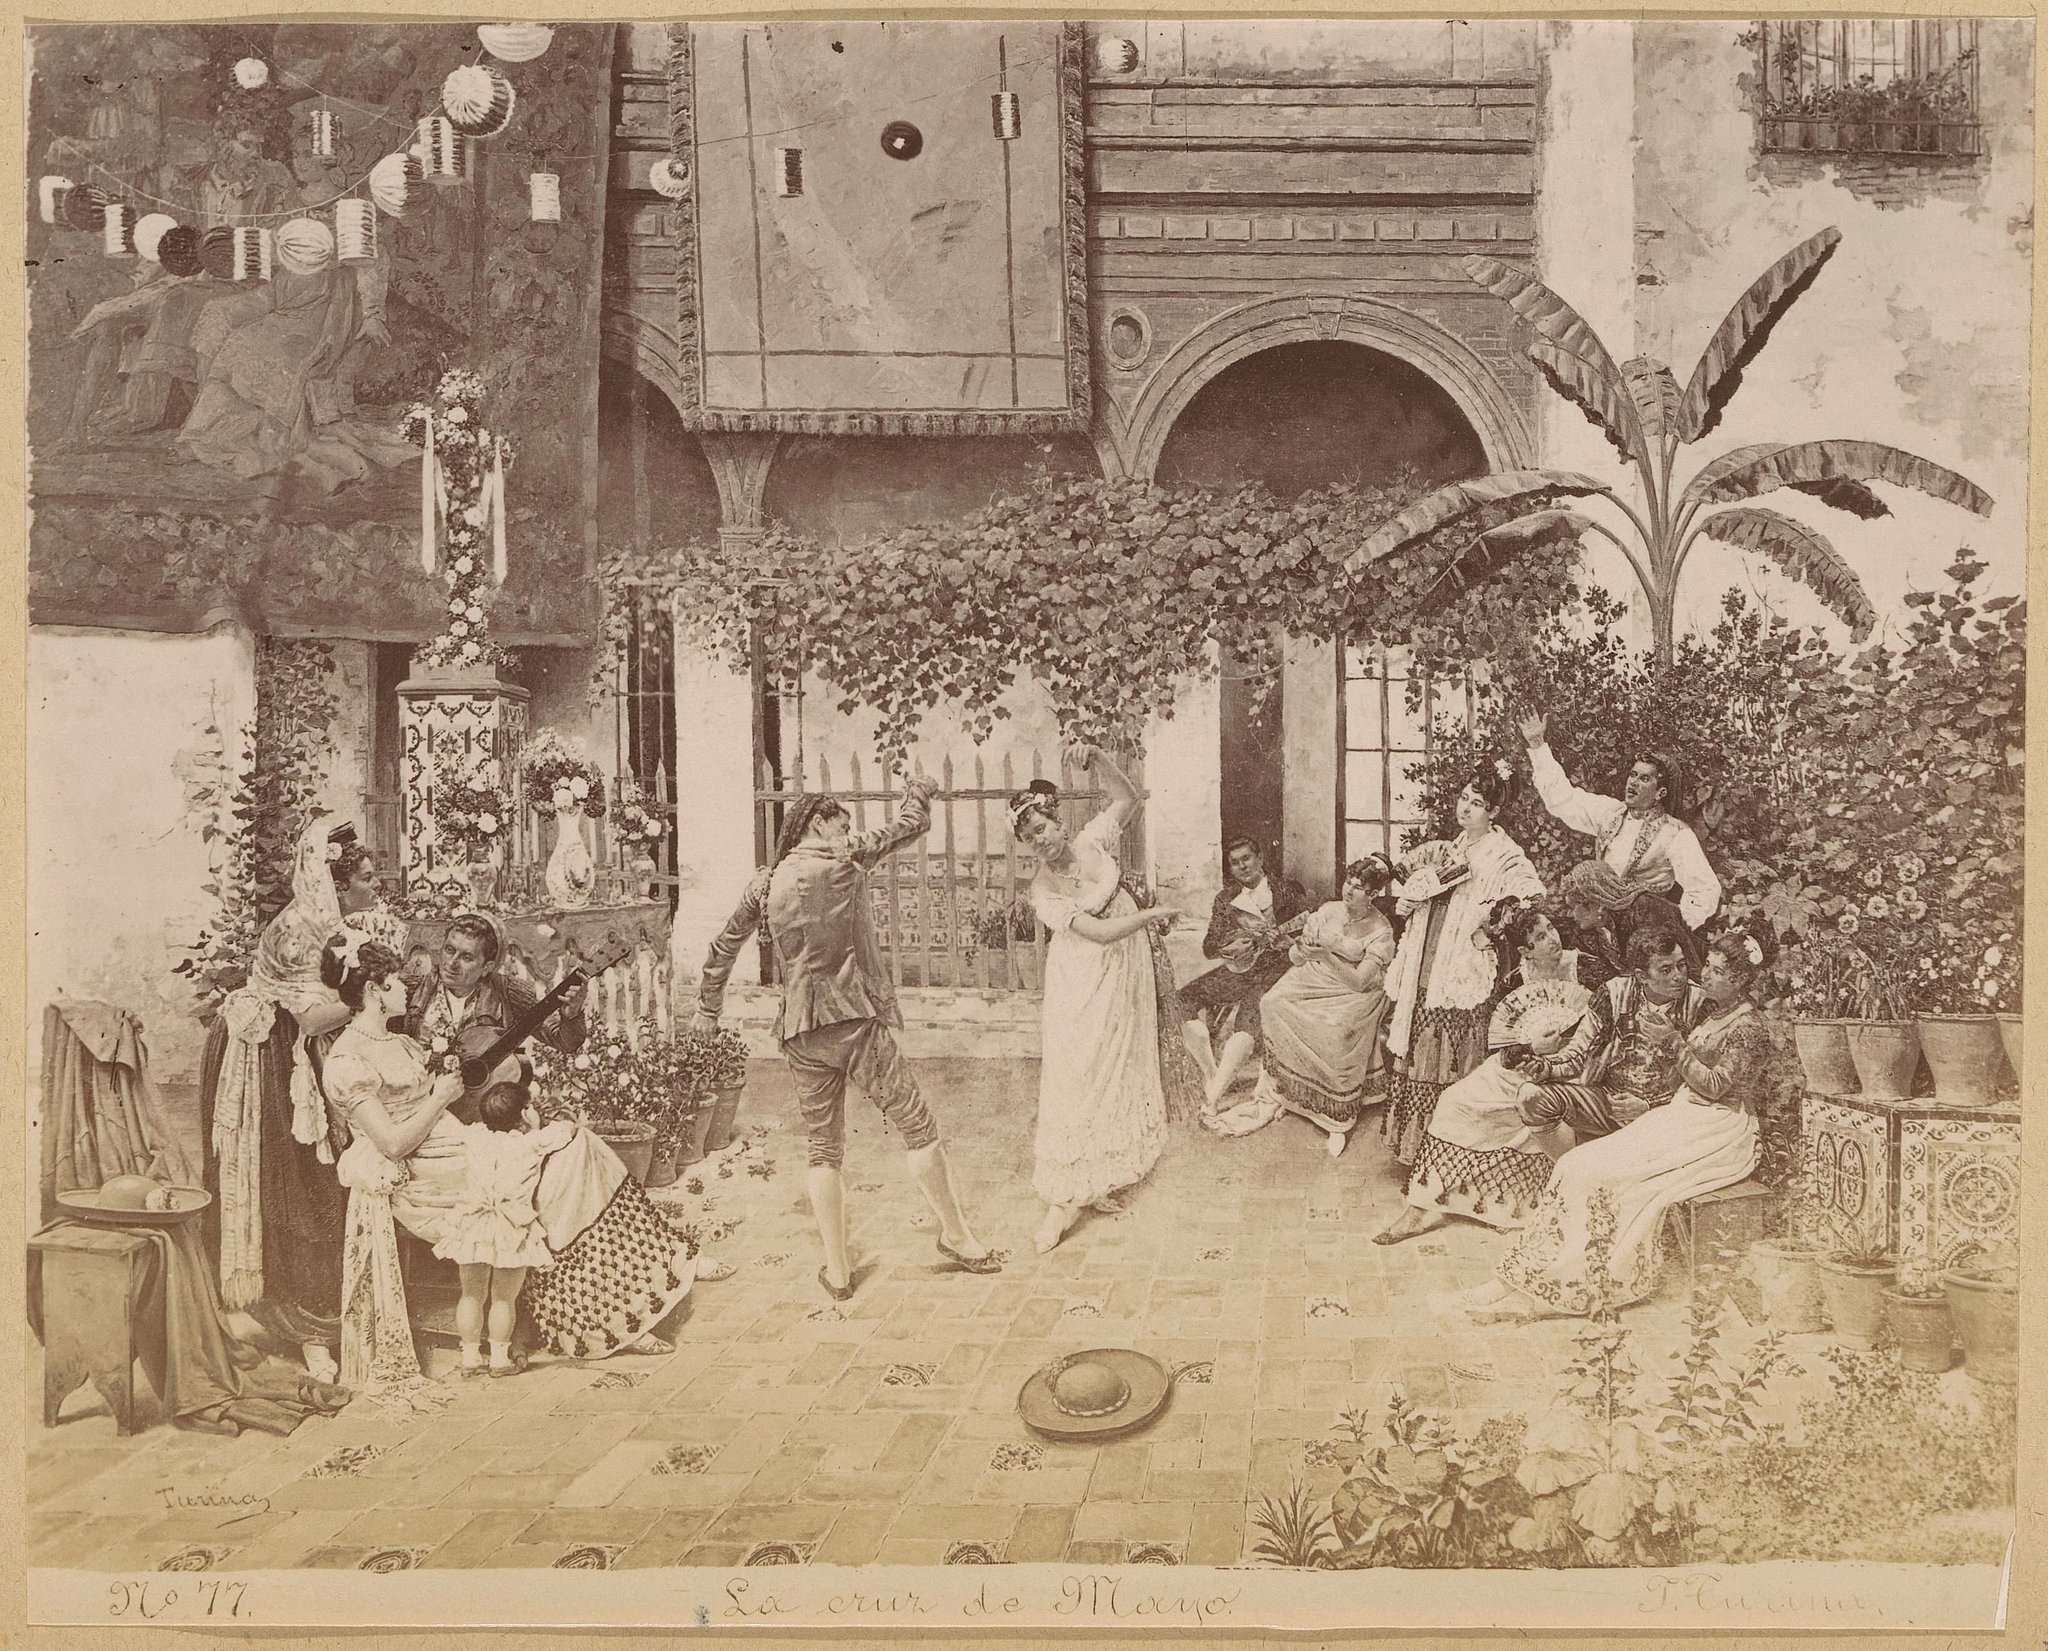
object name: reproduction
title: La cruz de Mayo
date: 1880-1905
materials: paper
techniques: albumen print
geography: sevilla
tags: public festivities, sevilla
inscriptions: number: ‘No 77.’